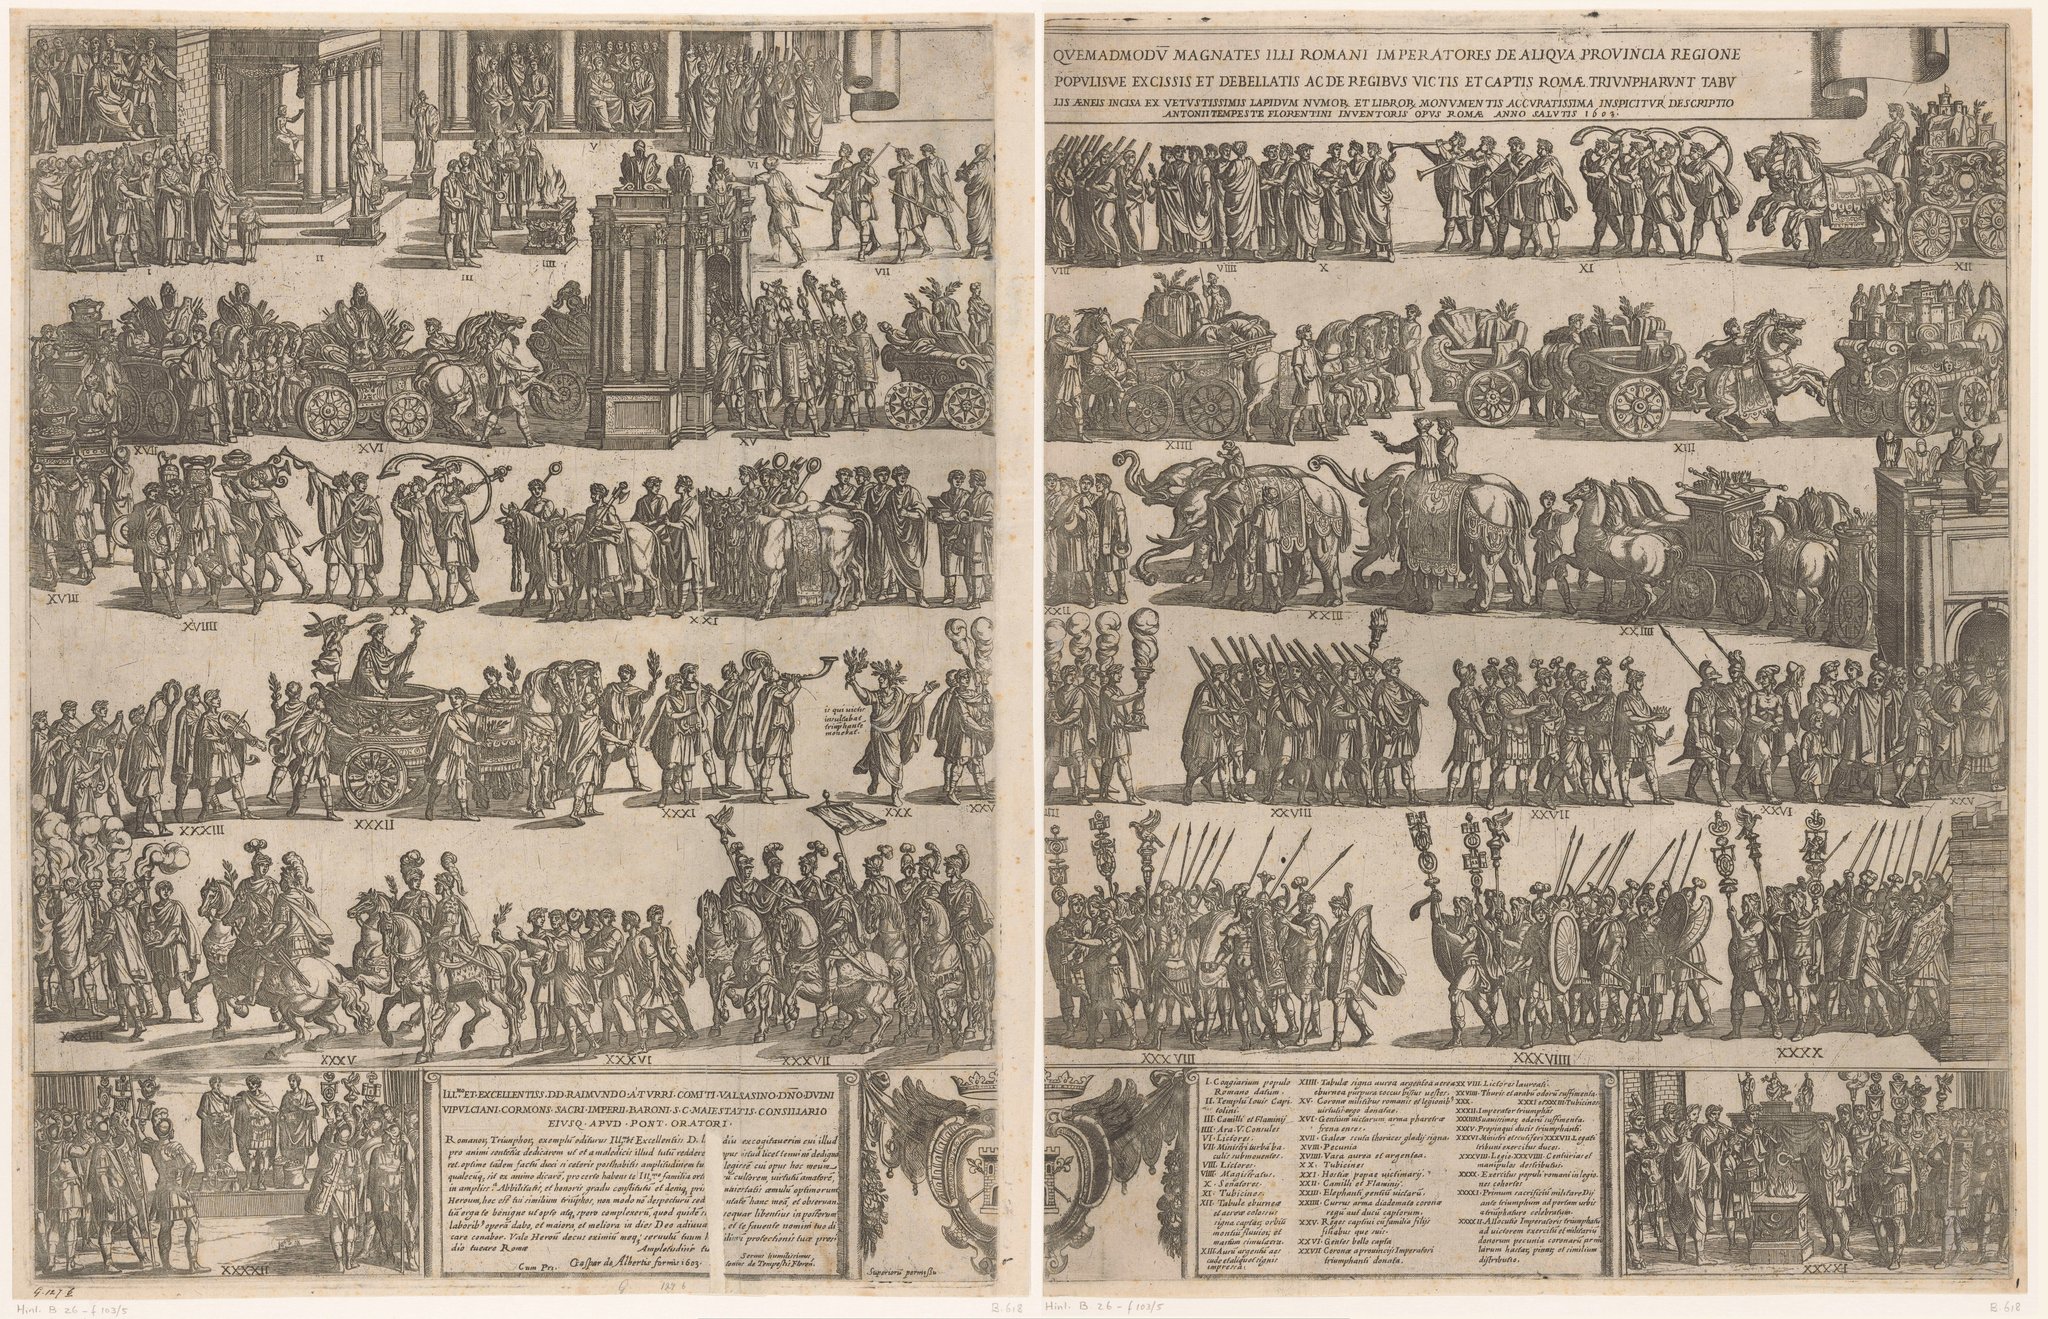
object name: print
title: Triomf van een Romeins keizer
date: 1603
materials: paper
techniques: etching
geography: vatican city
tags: triumphal arch, triumphal entry and public reception, pageant, 'entrée solennelle', 'joyeuse entrée', emperor, carrying off the spoils of war, division of the spoils of war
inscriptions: collector's mark: Lugt 11, number: ‘1’, collector's mark: ‘Hinloopen’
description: Een triomftocht van een Romeins keizer. De stoet trekt van rechtsonder, onder twee triomfbogen door, naar een tempel linksboven. De stoet bestaat uit soldaten, gevangenen, olifanten, wagens vol oorlogsbuit en de keizer. Linksonder een voorstelling van de keizer die de oorlogsbuit verdeelt. Rechtsonder een voorstelling van een offerscène en een verklarende lijst met nummers.